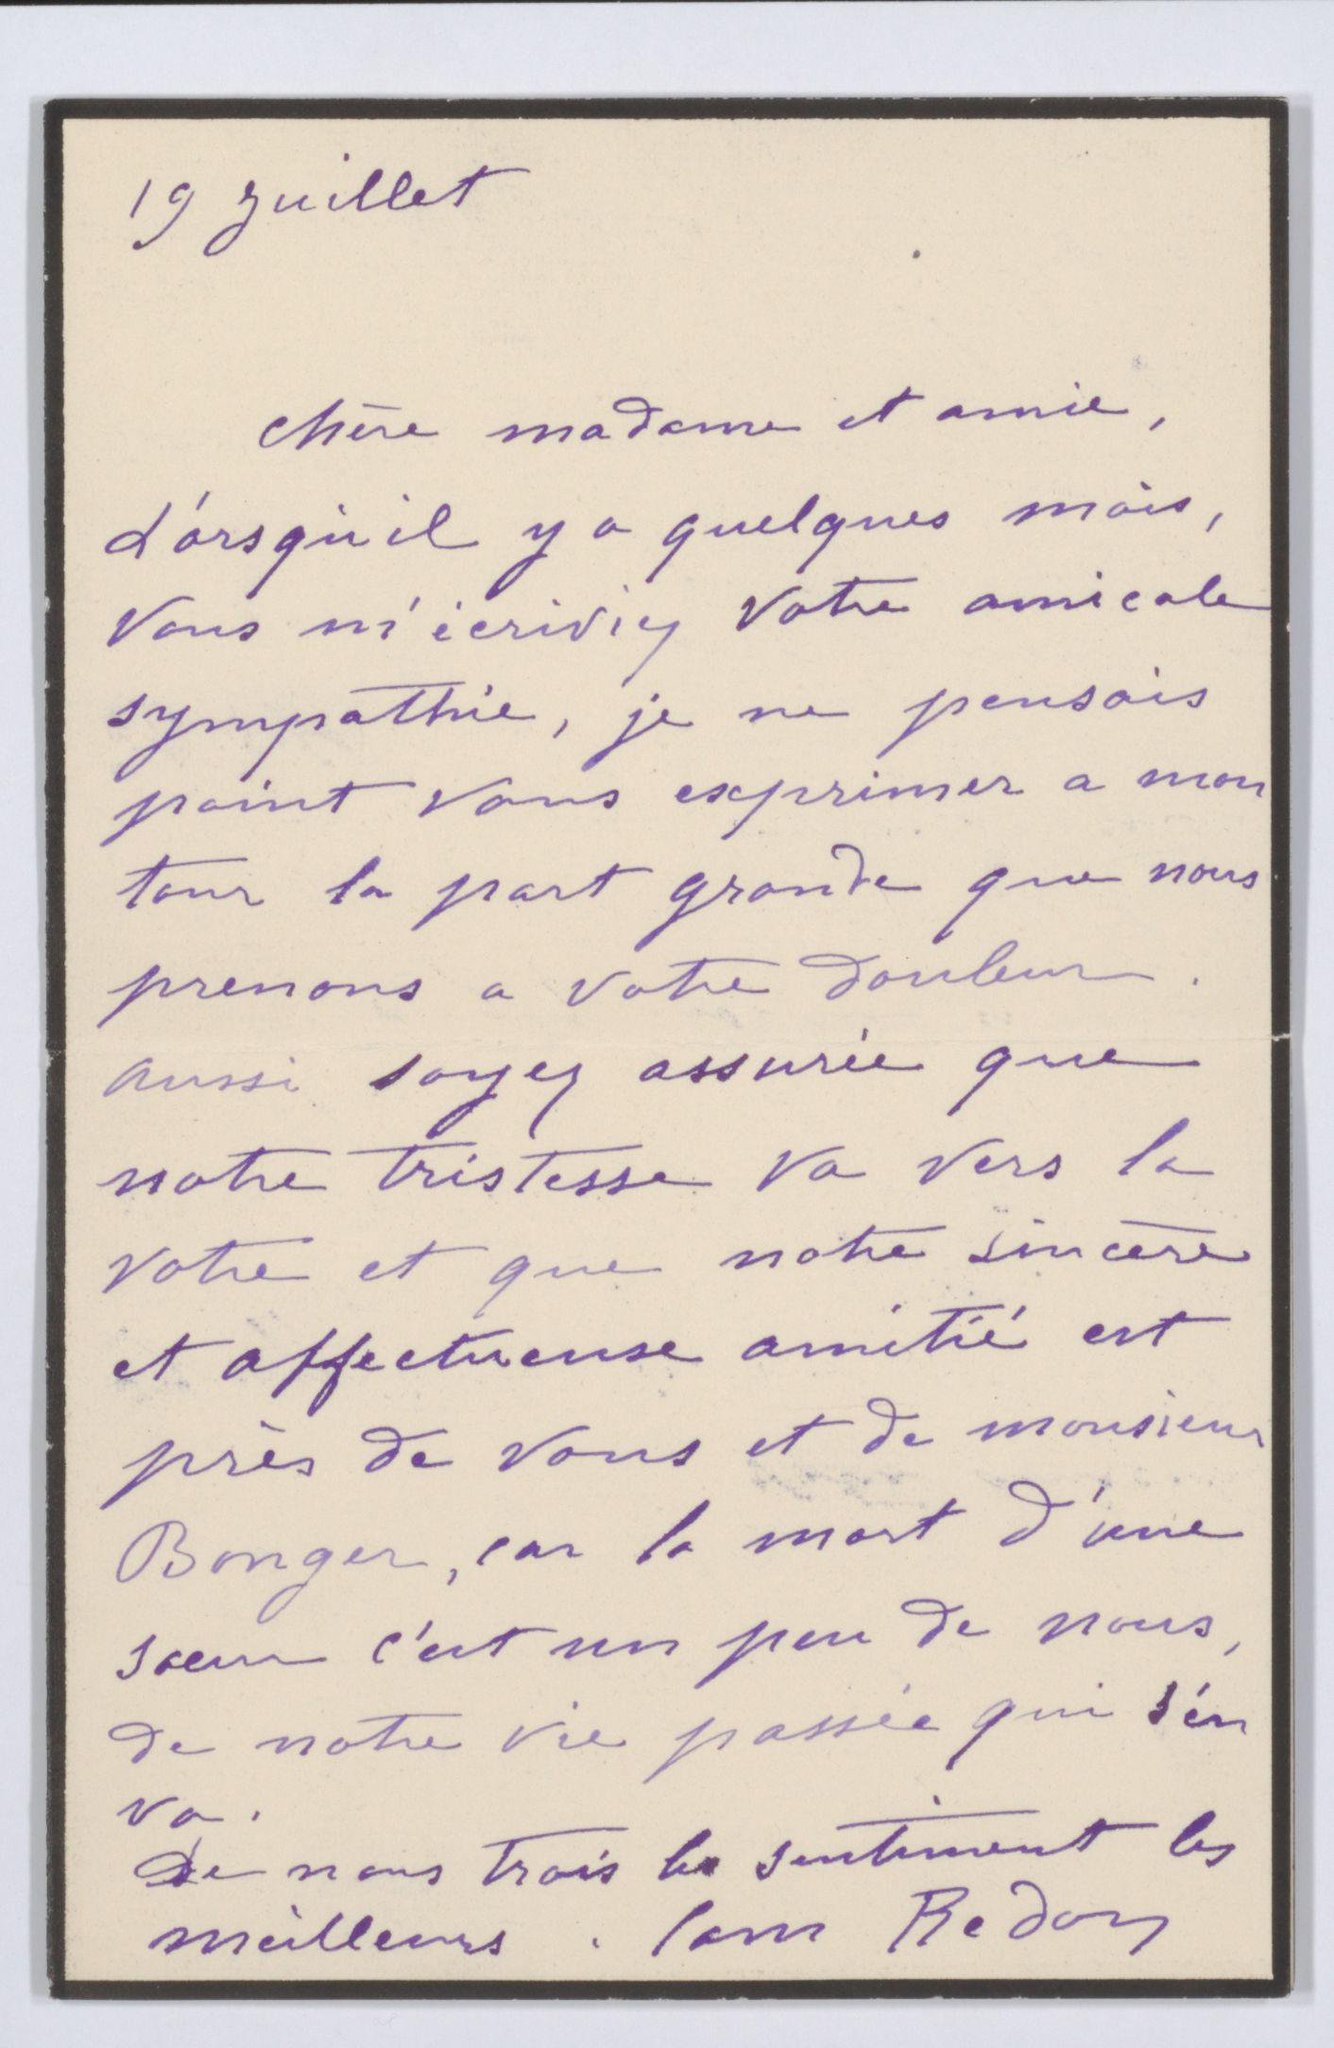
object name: letter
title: Brief aan Anne Marie Louise van der Linden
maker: camille redon-falte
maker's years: 1853-1923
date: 1913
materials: ink, paper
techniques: pen, writing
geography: paris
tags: passions, emotions, affections, family life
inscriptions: watermark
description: Brief behoort tot een album samengesteld door weduwe Françoise W.M. Barones van der Borch van Verwolde met afschriften van brieven met betrekking tot (de familie van) Odilon Redon. De brief werd bewaard op pagina 101.